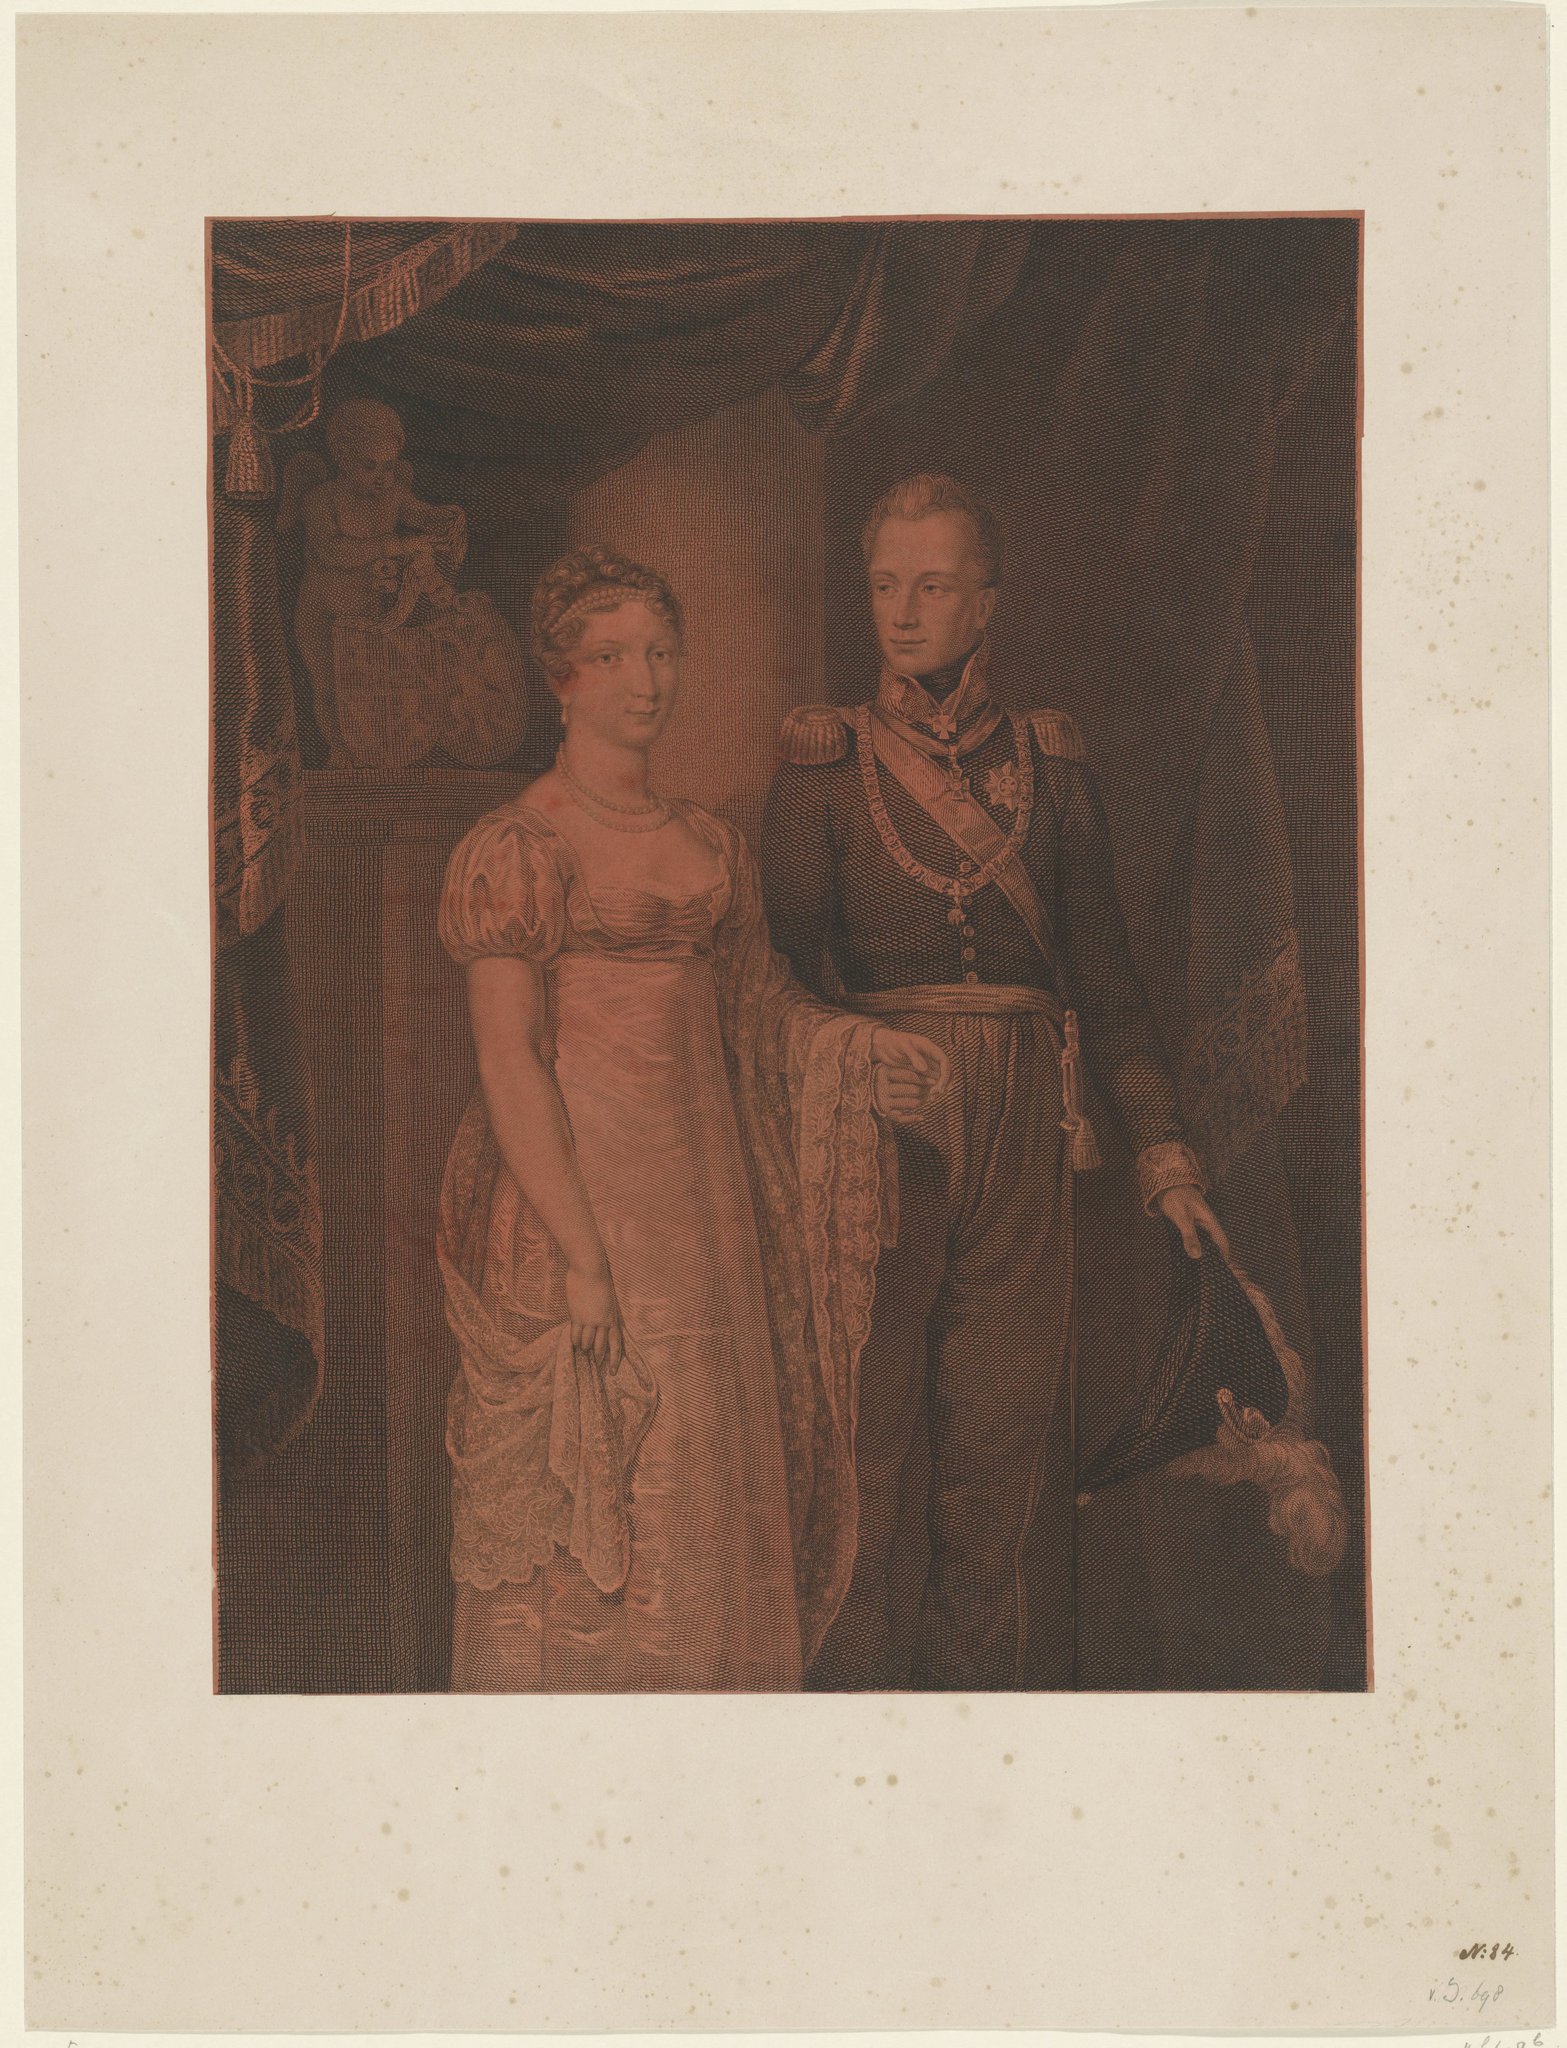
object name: print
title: Portret van Willem II, koning der Nederlanden, en Anna Paulowna Romanowa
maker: philippus velijn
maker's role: print maker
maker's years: 1787-1836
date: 1816-1836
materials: paper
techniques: engraving, etching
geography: netherlands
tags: anna paulowna romanowa, the hague, william ii of the netherlands, knighthood order of the golden fleece - insignia of a knighthood order, e.g.: badge, chain (with name of order)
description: De hier vermelde titel verwijst naar de hoogst verkregen titel van de geportretteerde, niet per se naar de titel die de geportretteerde op deze voorstelling draagt.